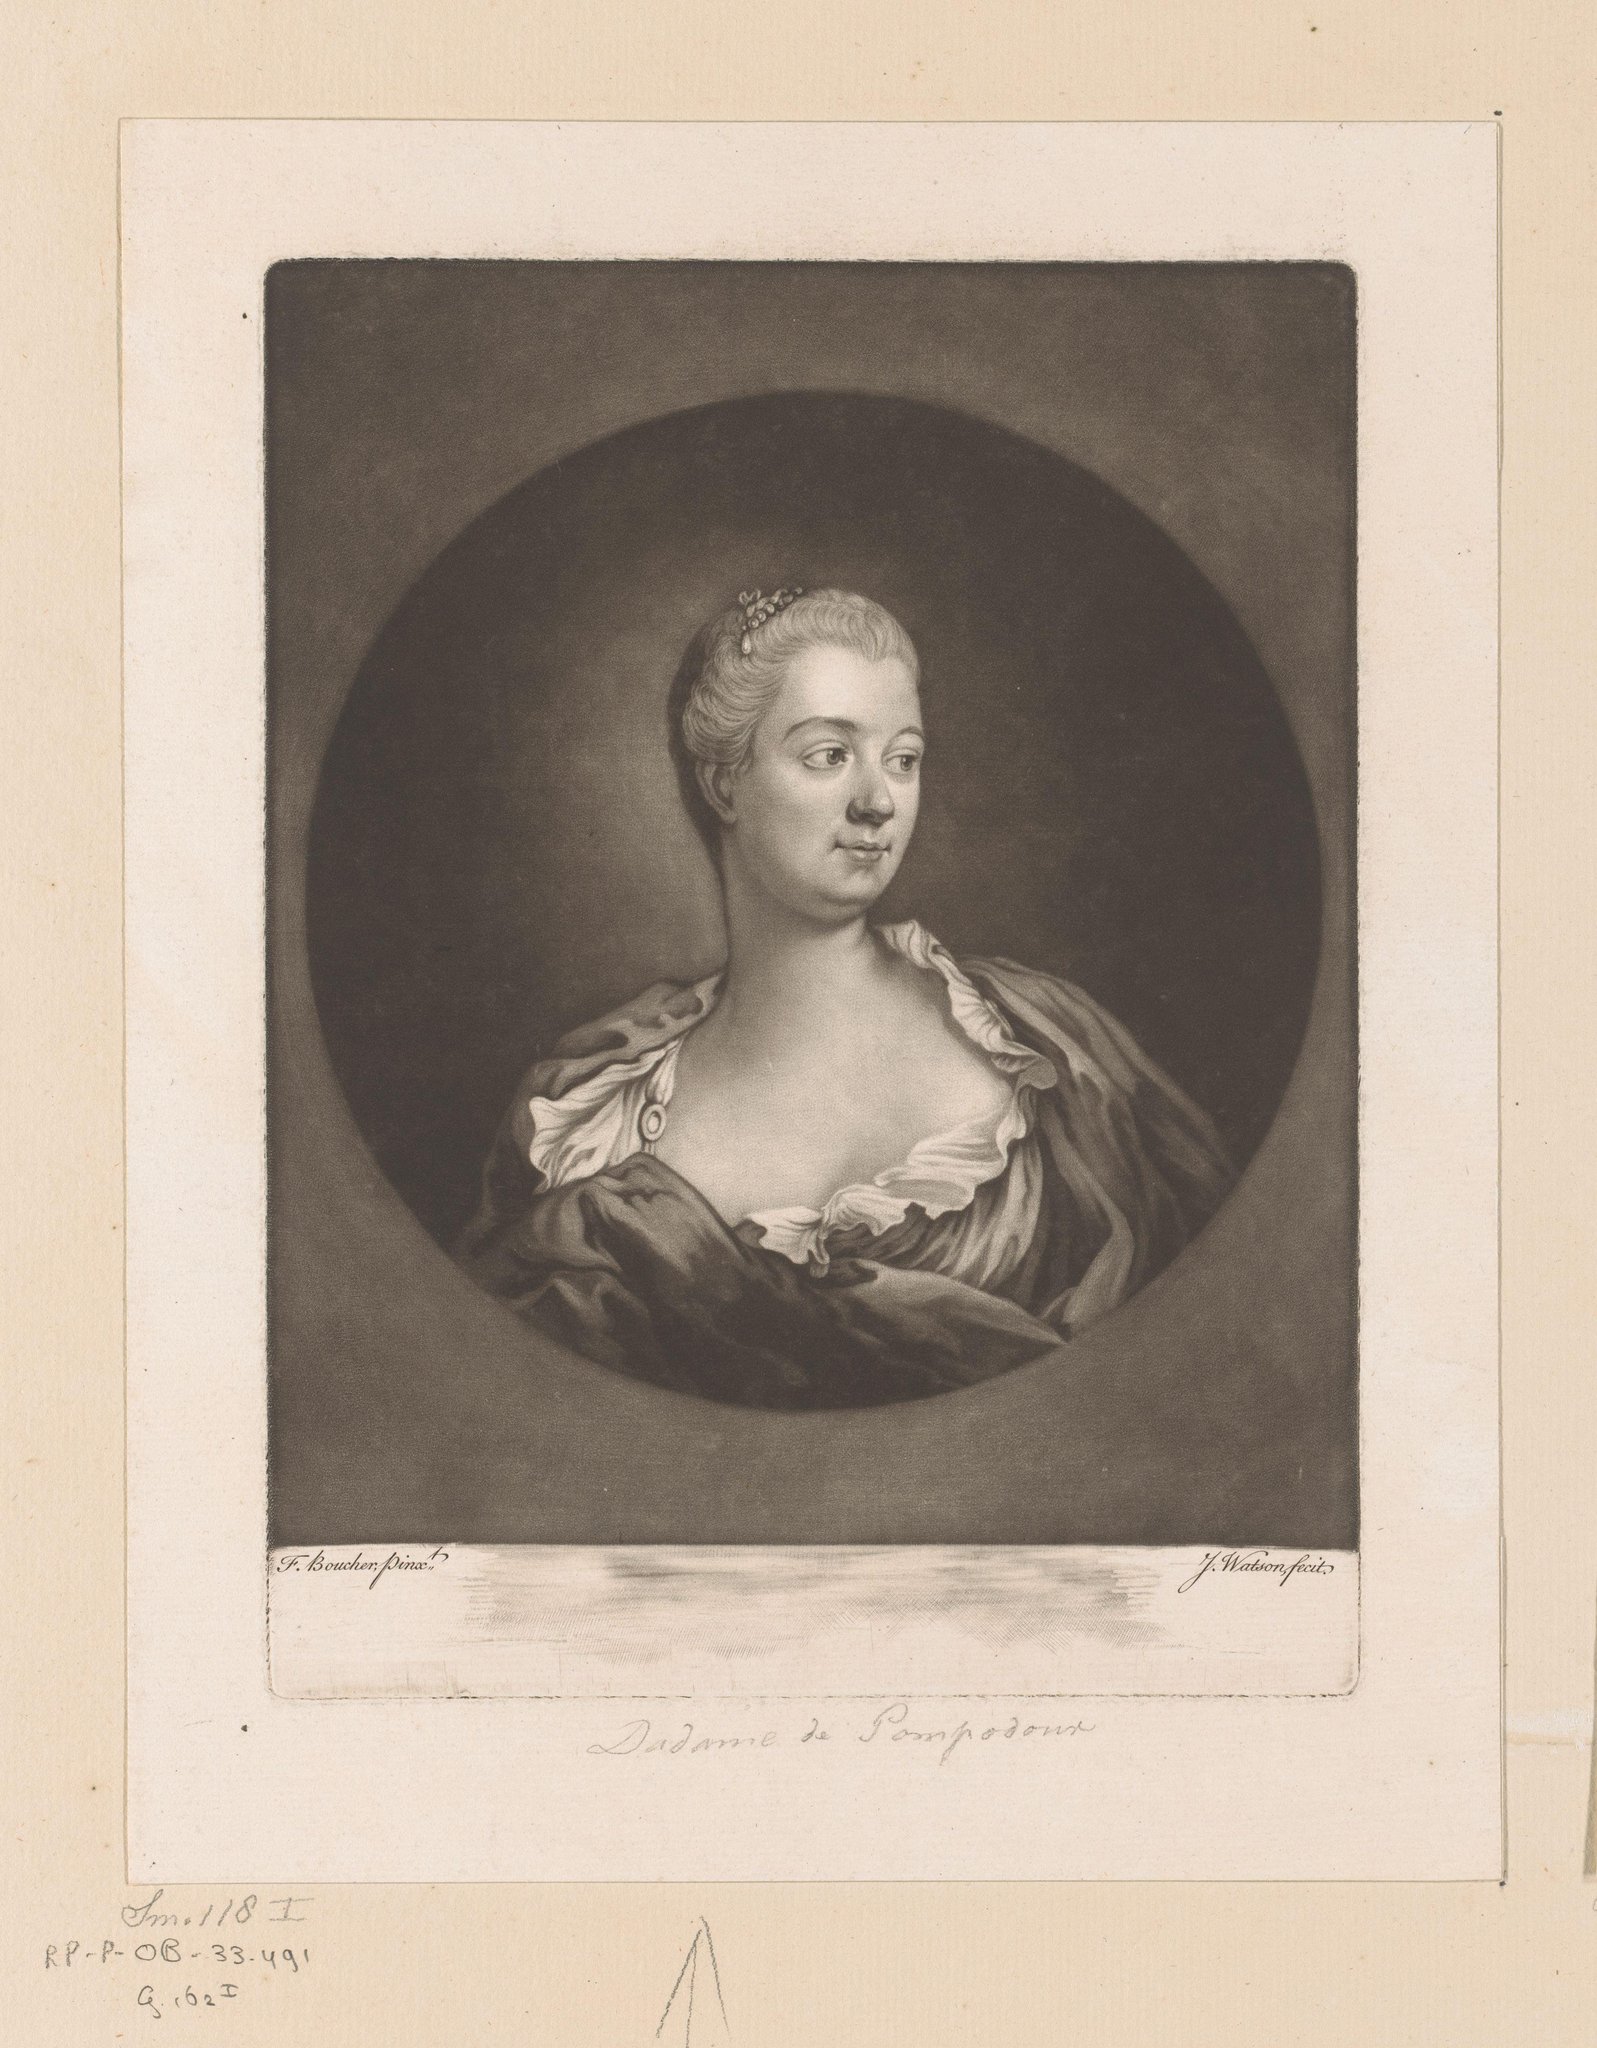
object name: print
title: Portret van Madame de Pompadour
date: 1765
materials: paper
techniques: mezzotint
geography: london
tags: paris, madame de pompadour, historical persons - bb - woman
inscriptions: collector's mark: Lugt 240